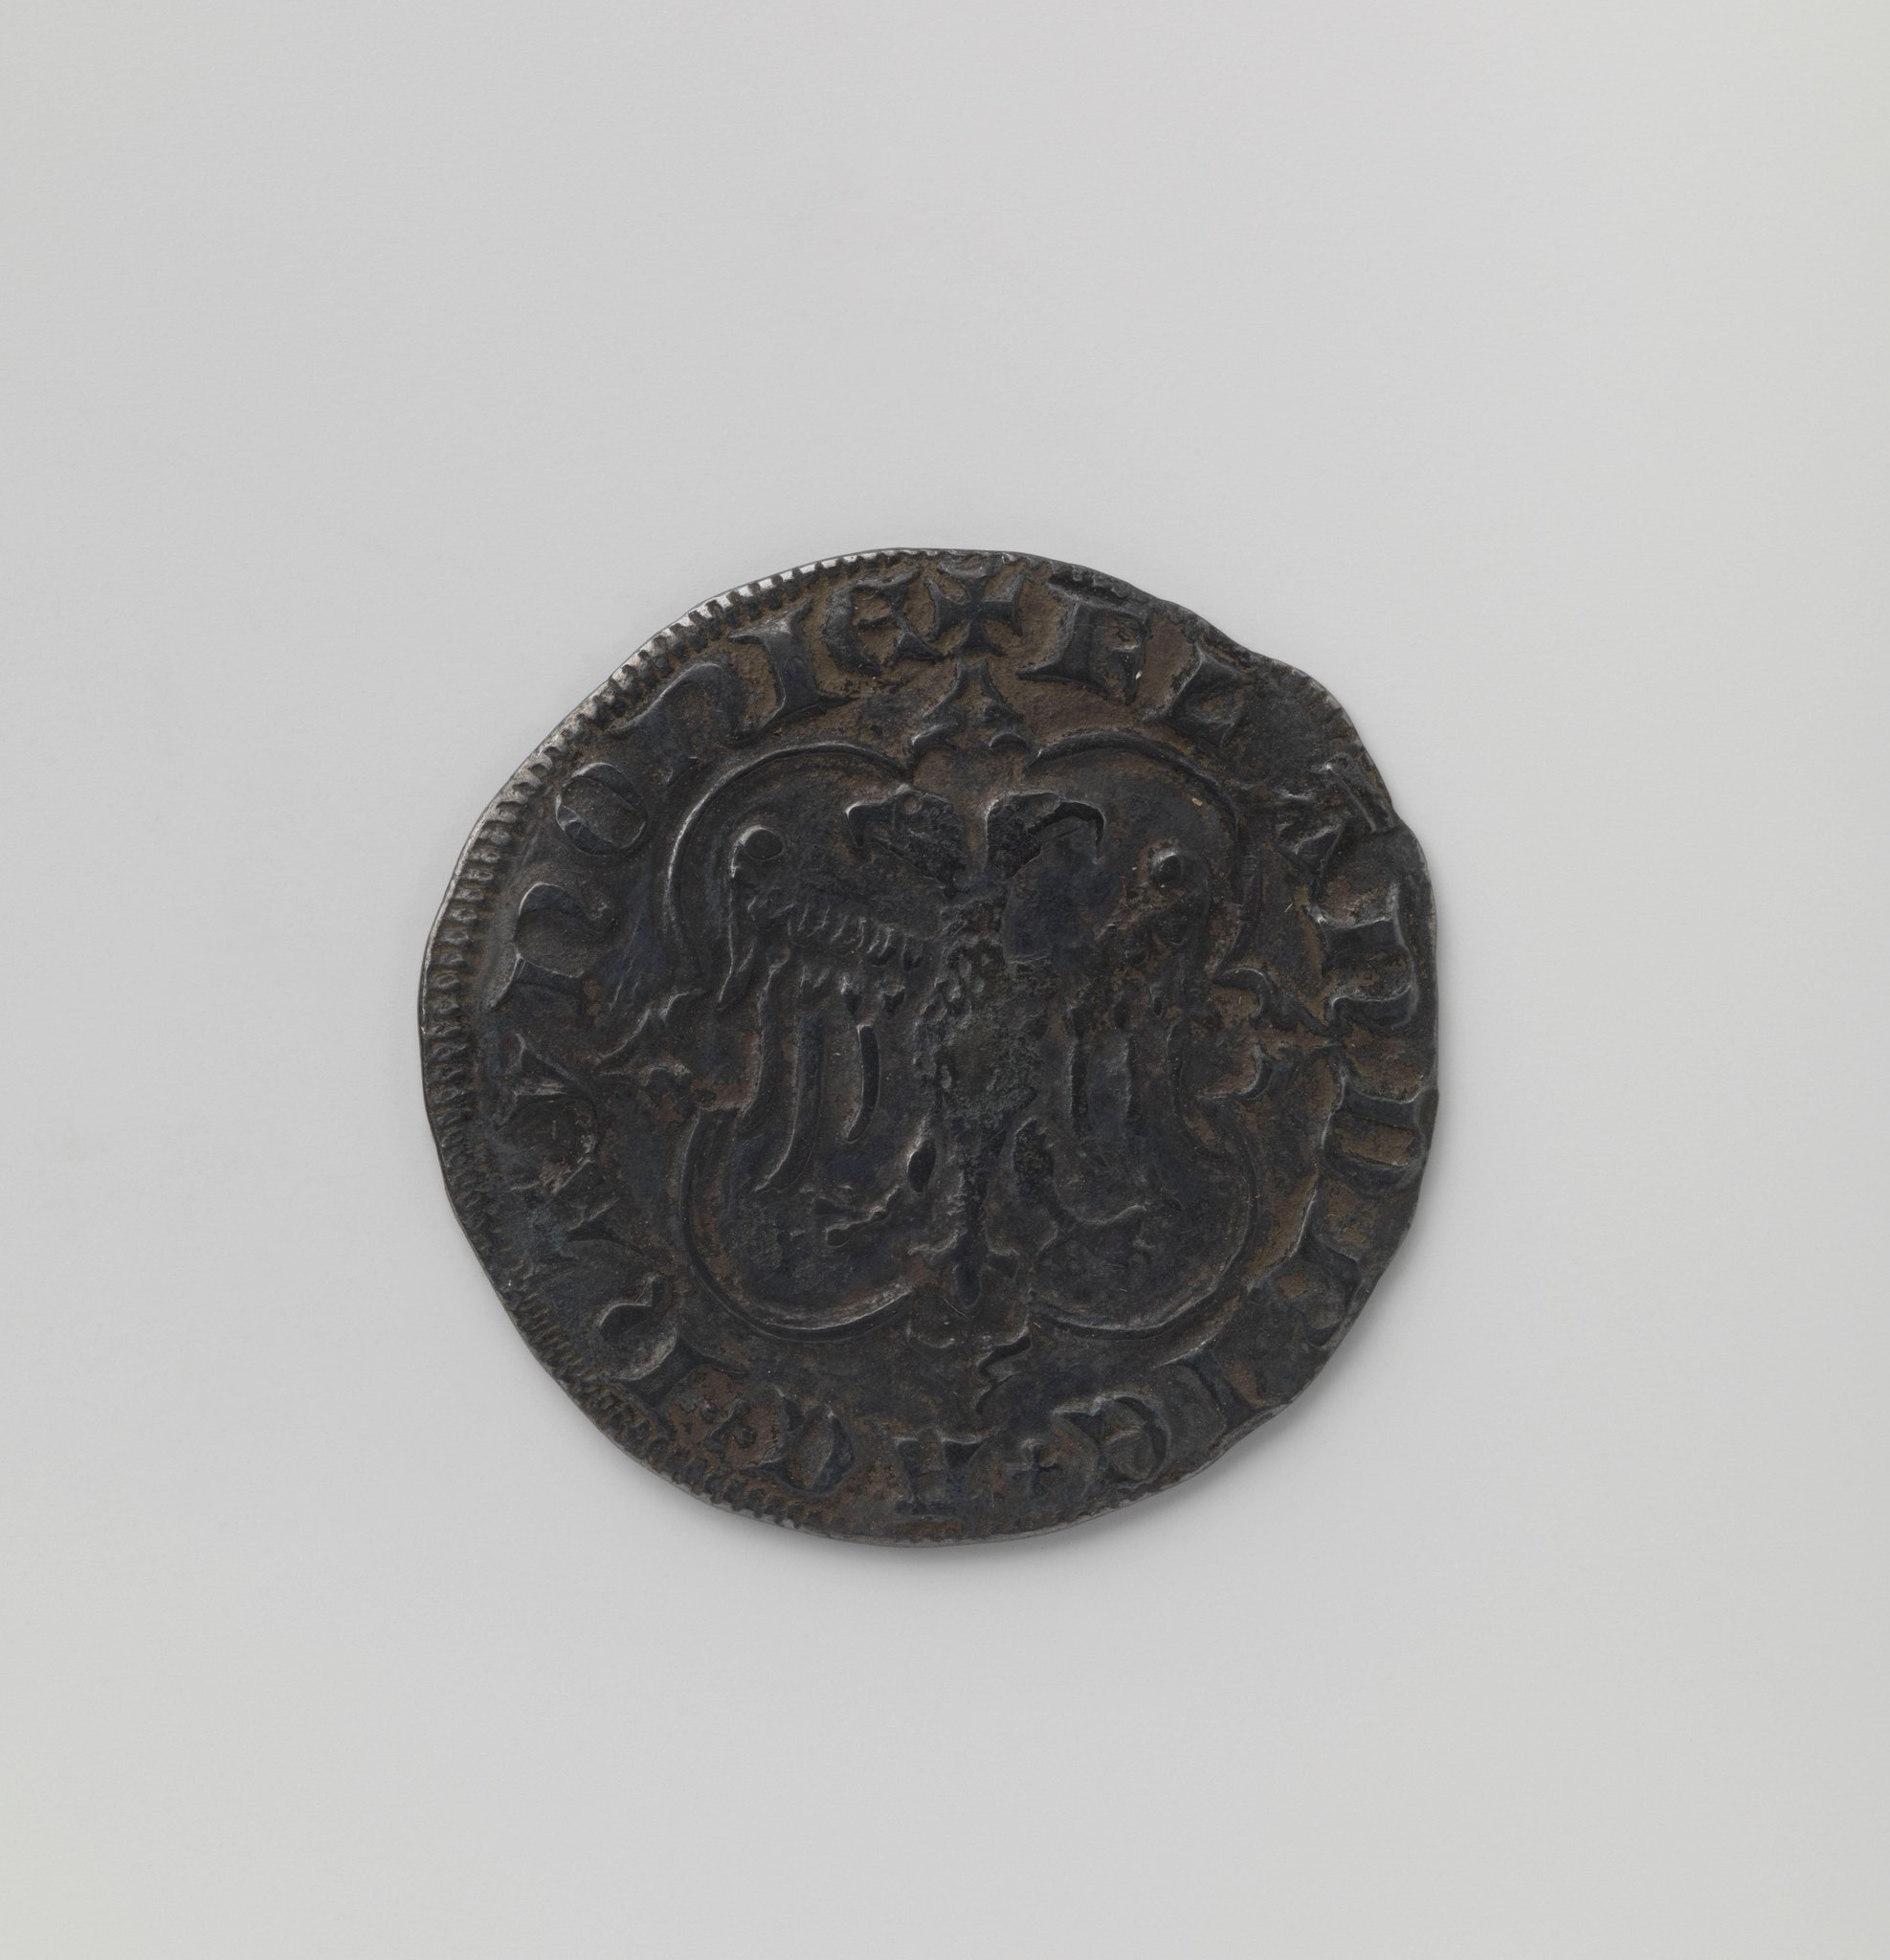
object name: coin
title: adelaarsgroot uit Vlaanderen van Margaretha van Constantinopel, 1244-1280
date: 1244-1280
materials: silver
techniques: striking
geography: aalst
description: Voorzijde: binnen versierde vierpas dubbelkoppige adelaar. Keerzijde: kort versierd en gebloemd kruis, in hoeken letters A, L, O en S.